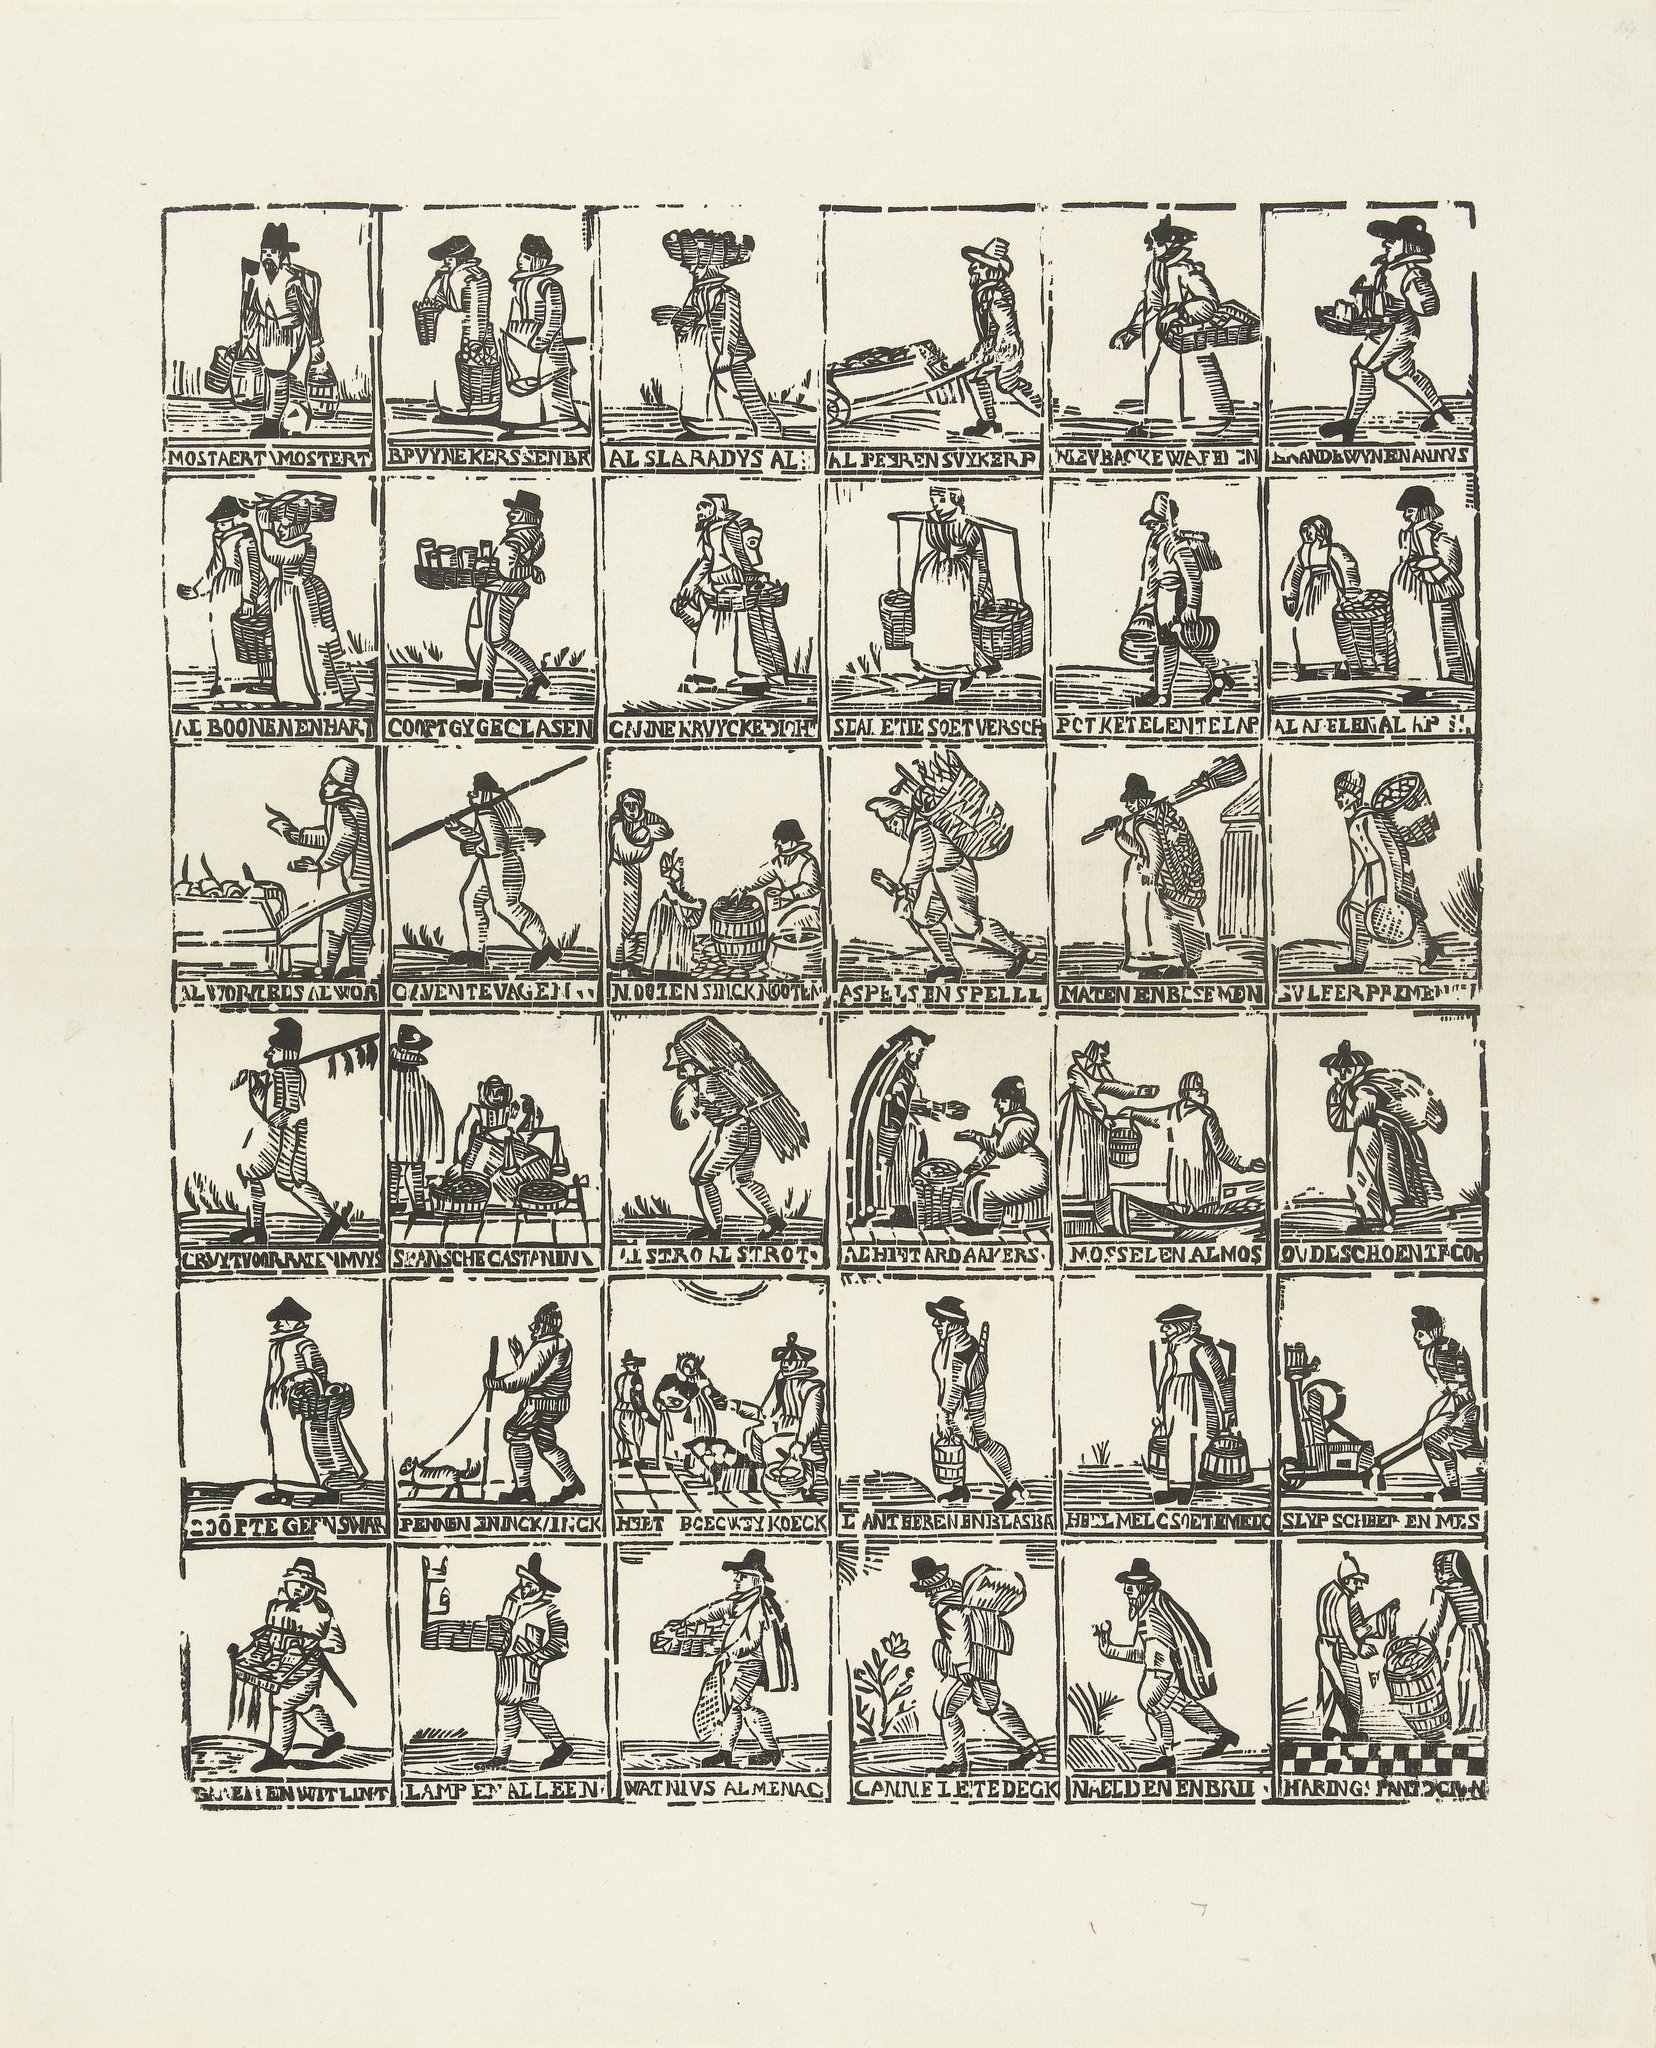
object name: print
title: Straatroepen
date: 1700-1725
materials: paper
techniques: woodcut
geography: southern netherlands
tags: 'cris de paris', cries of london, etc.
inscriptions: collector's mark: Lugt 2760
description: Blad met 36 voorstellingen van straathandelaren met hun roepen. Onder elk plaatje de roep in het onderschrift.